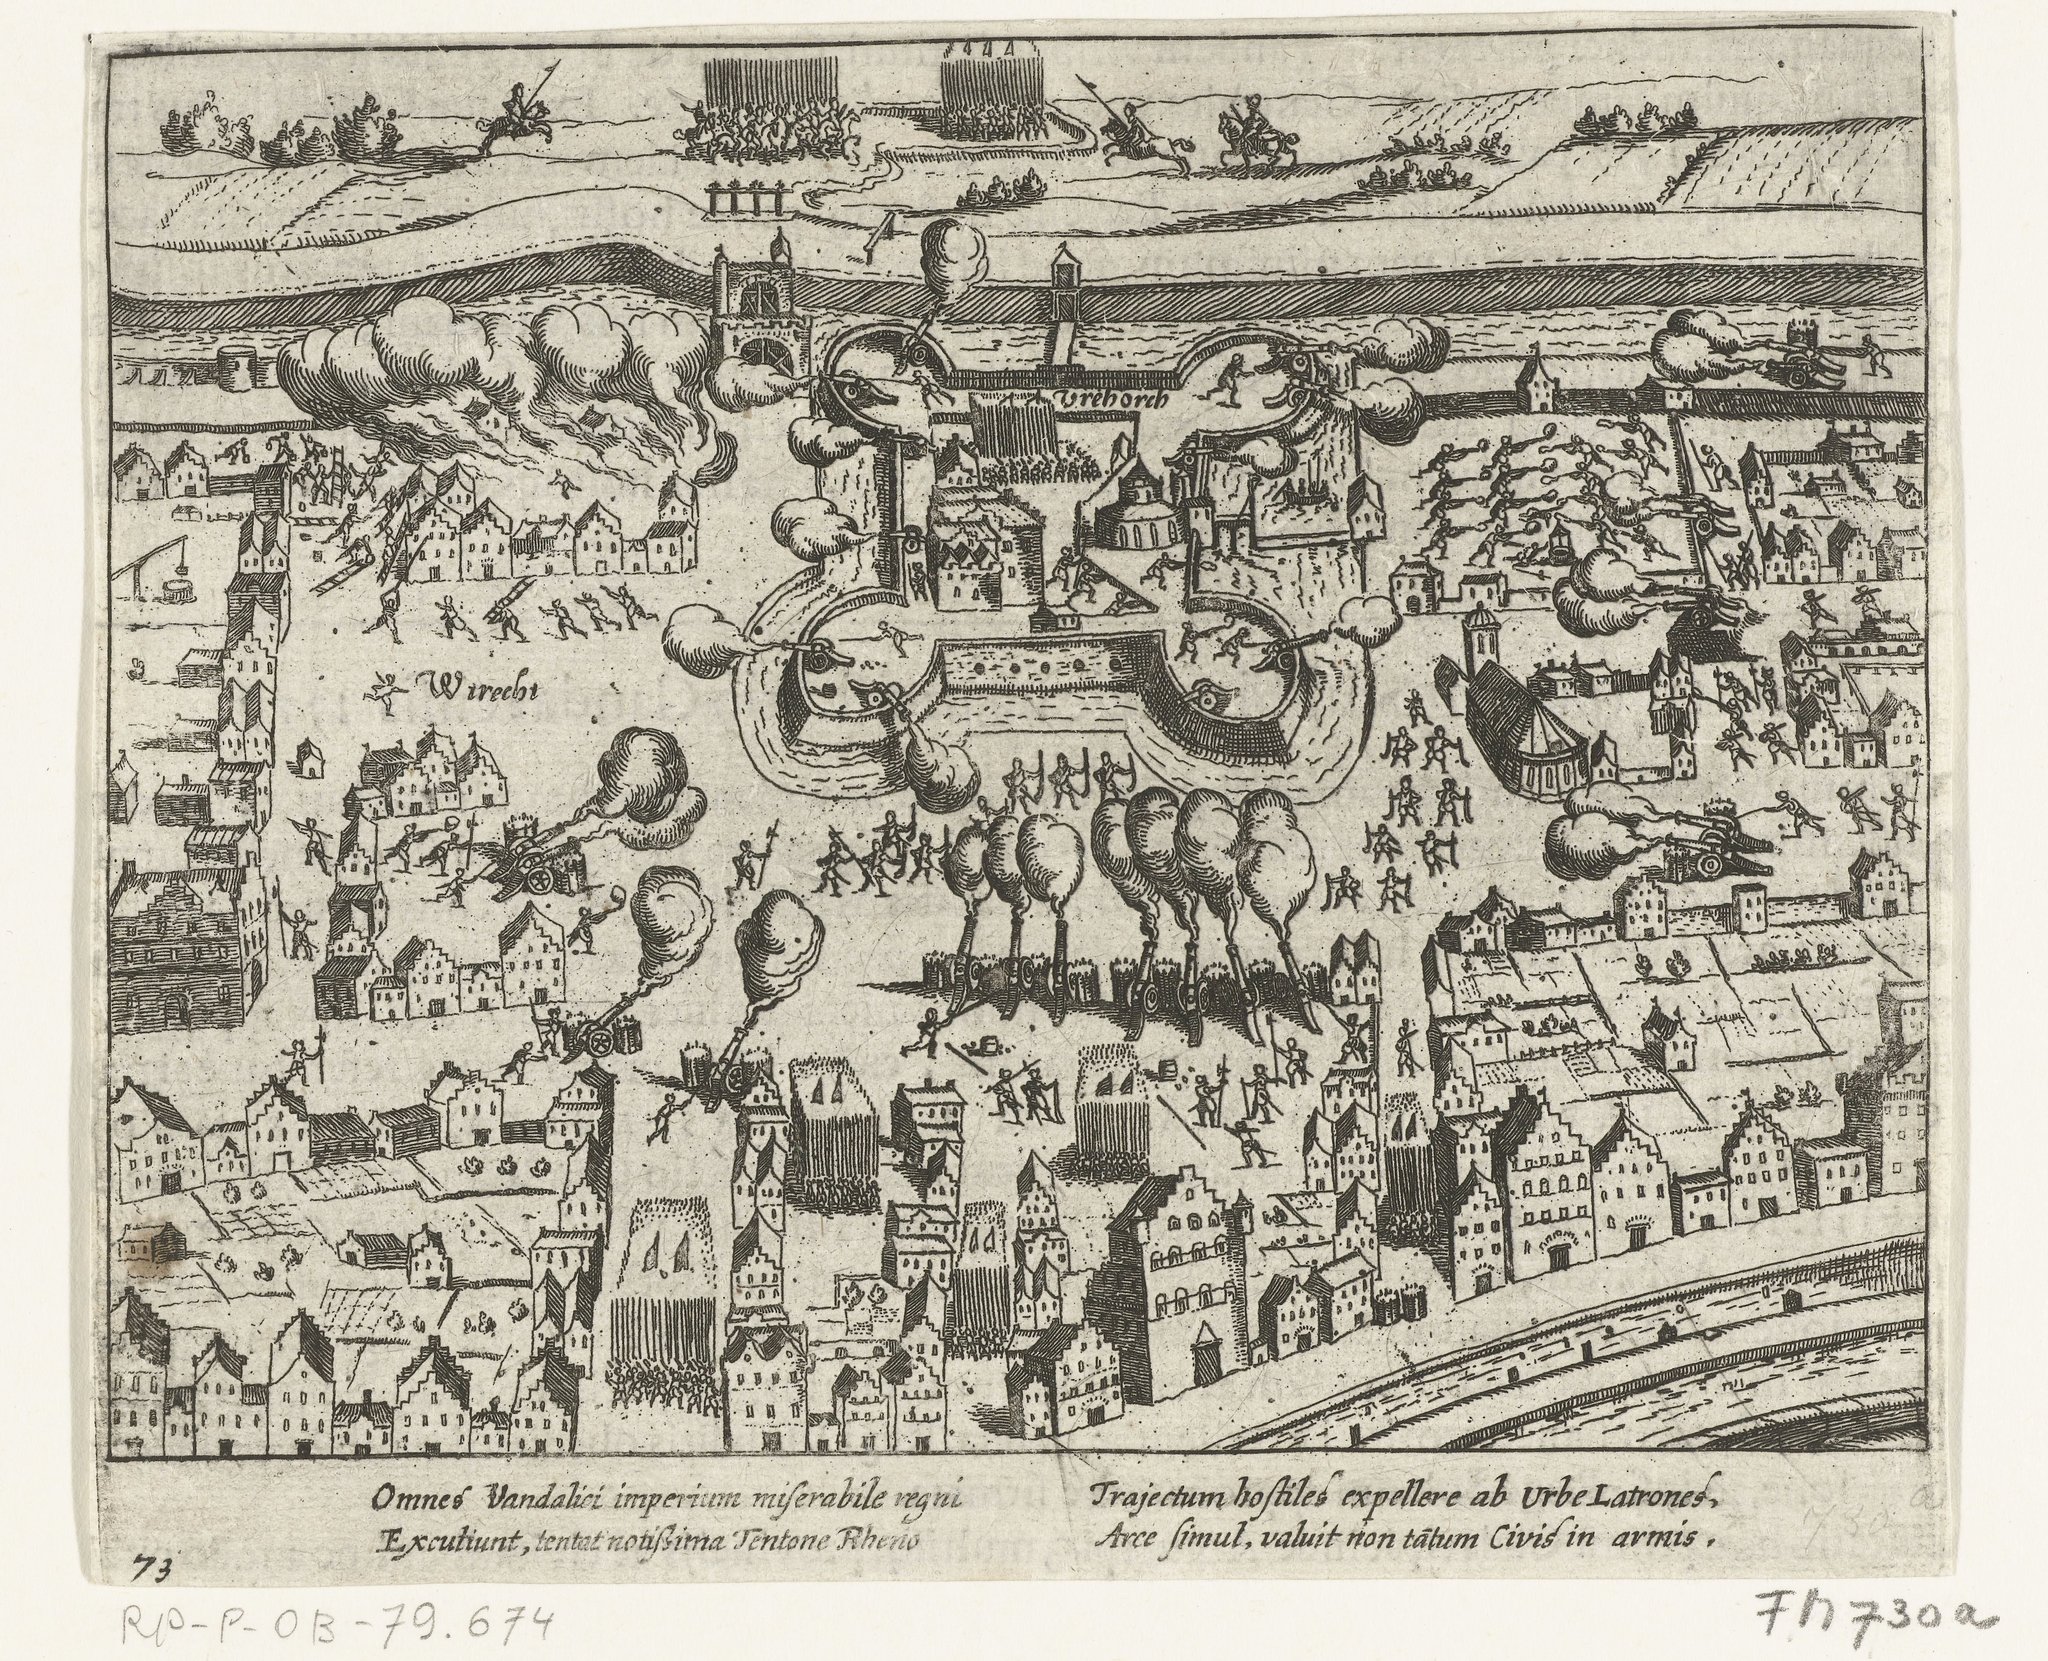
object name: history print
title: Beleg van Vredenburg, 1577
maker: simon frisius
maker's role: print maker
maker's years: 1570-1628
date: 1613-1615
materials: paper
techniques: pen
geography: northern netherlands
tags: siege, position war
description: Beleg en inname van het slot Vredenburg te Utrecht door het Staatse leger onder bevel van Bossu, 11 februari 1577. Gezicht op het fort en de omliggende straten met de diverse schermutselingen. Met onderschrift van 4 regels in het Latijn. Genummerd: 73. Bedrukt op achterzijde met tekst in het Latijn.